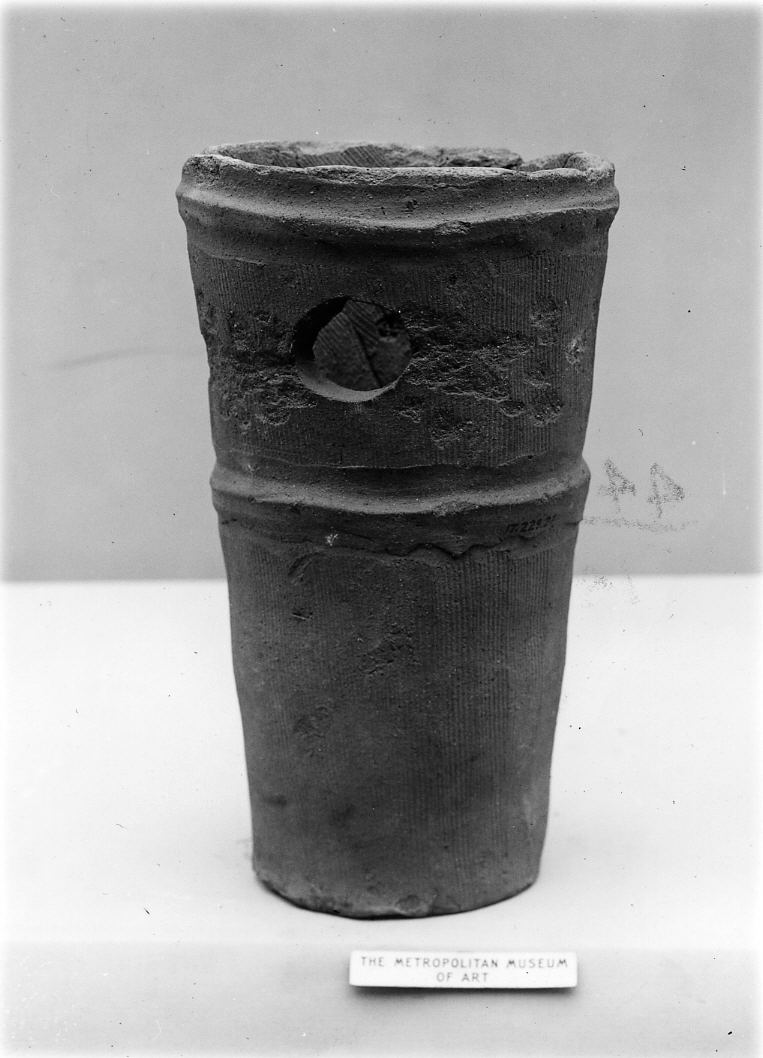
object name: haniwa base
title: Haniwa Base of a Figure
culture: japanese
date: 201-600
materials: earthenware